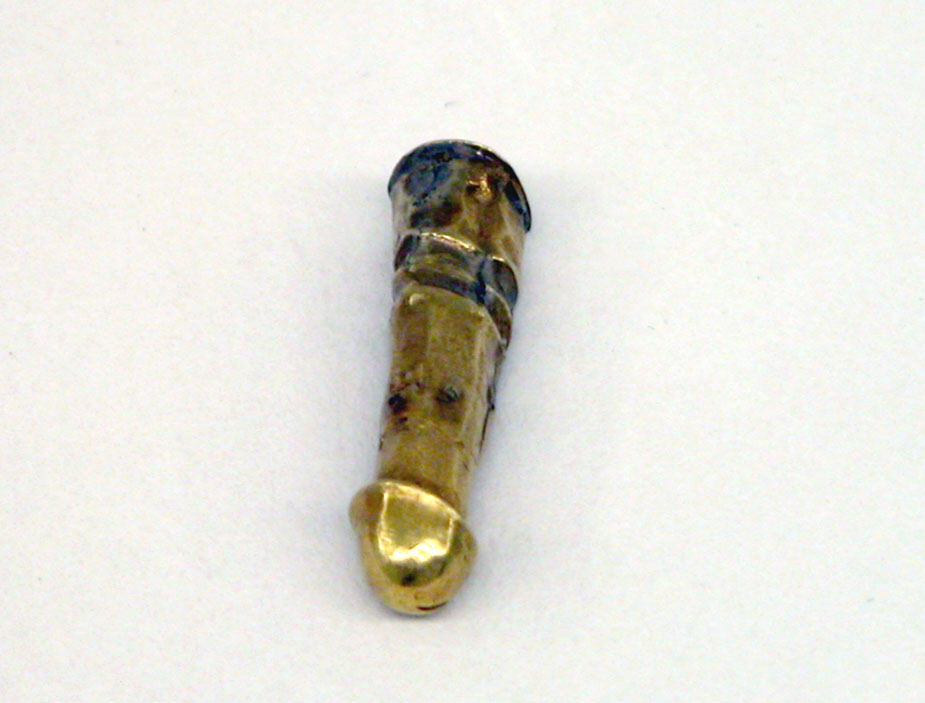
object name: linga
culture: indonesian, javanese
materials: gold